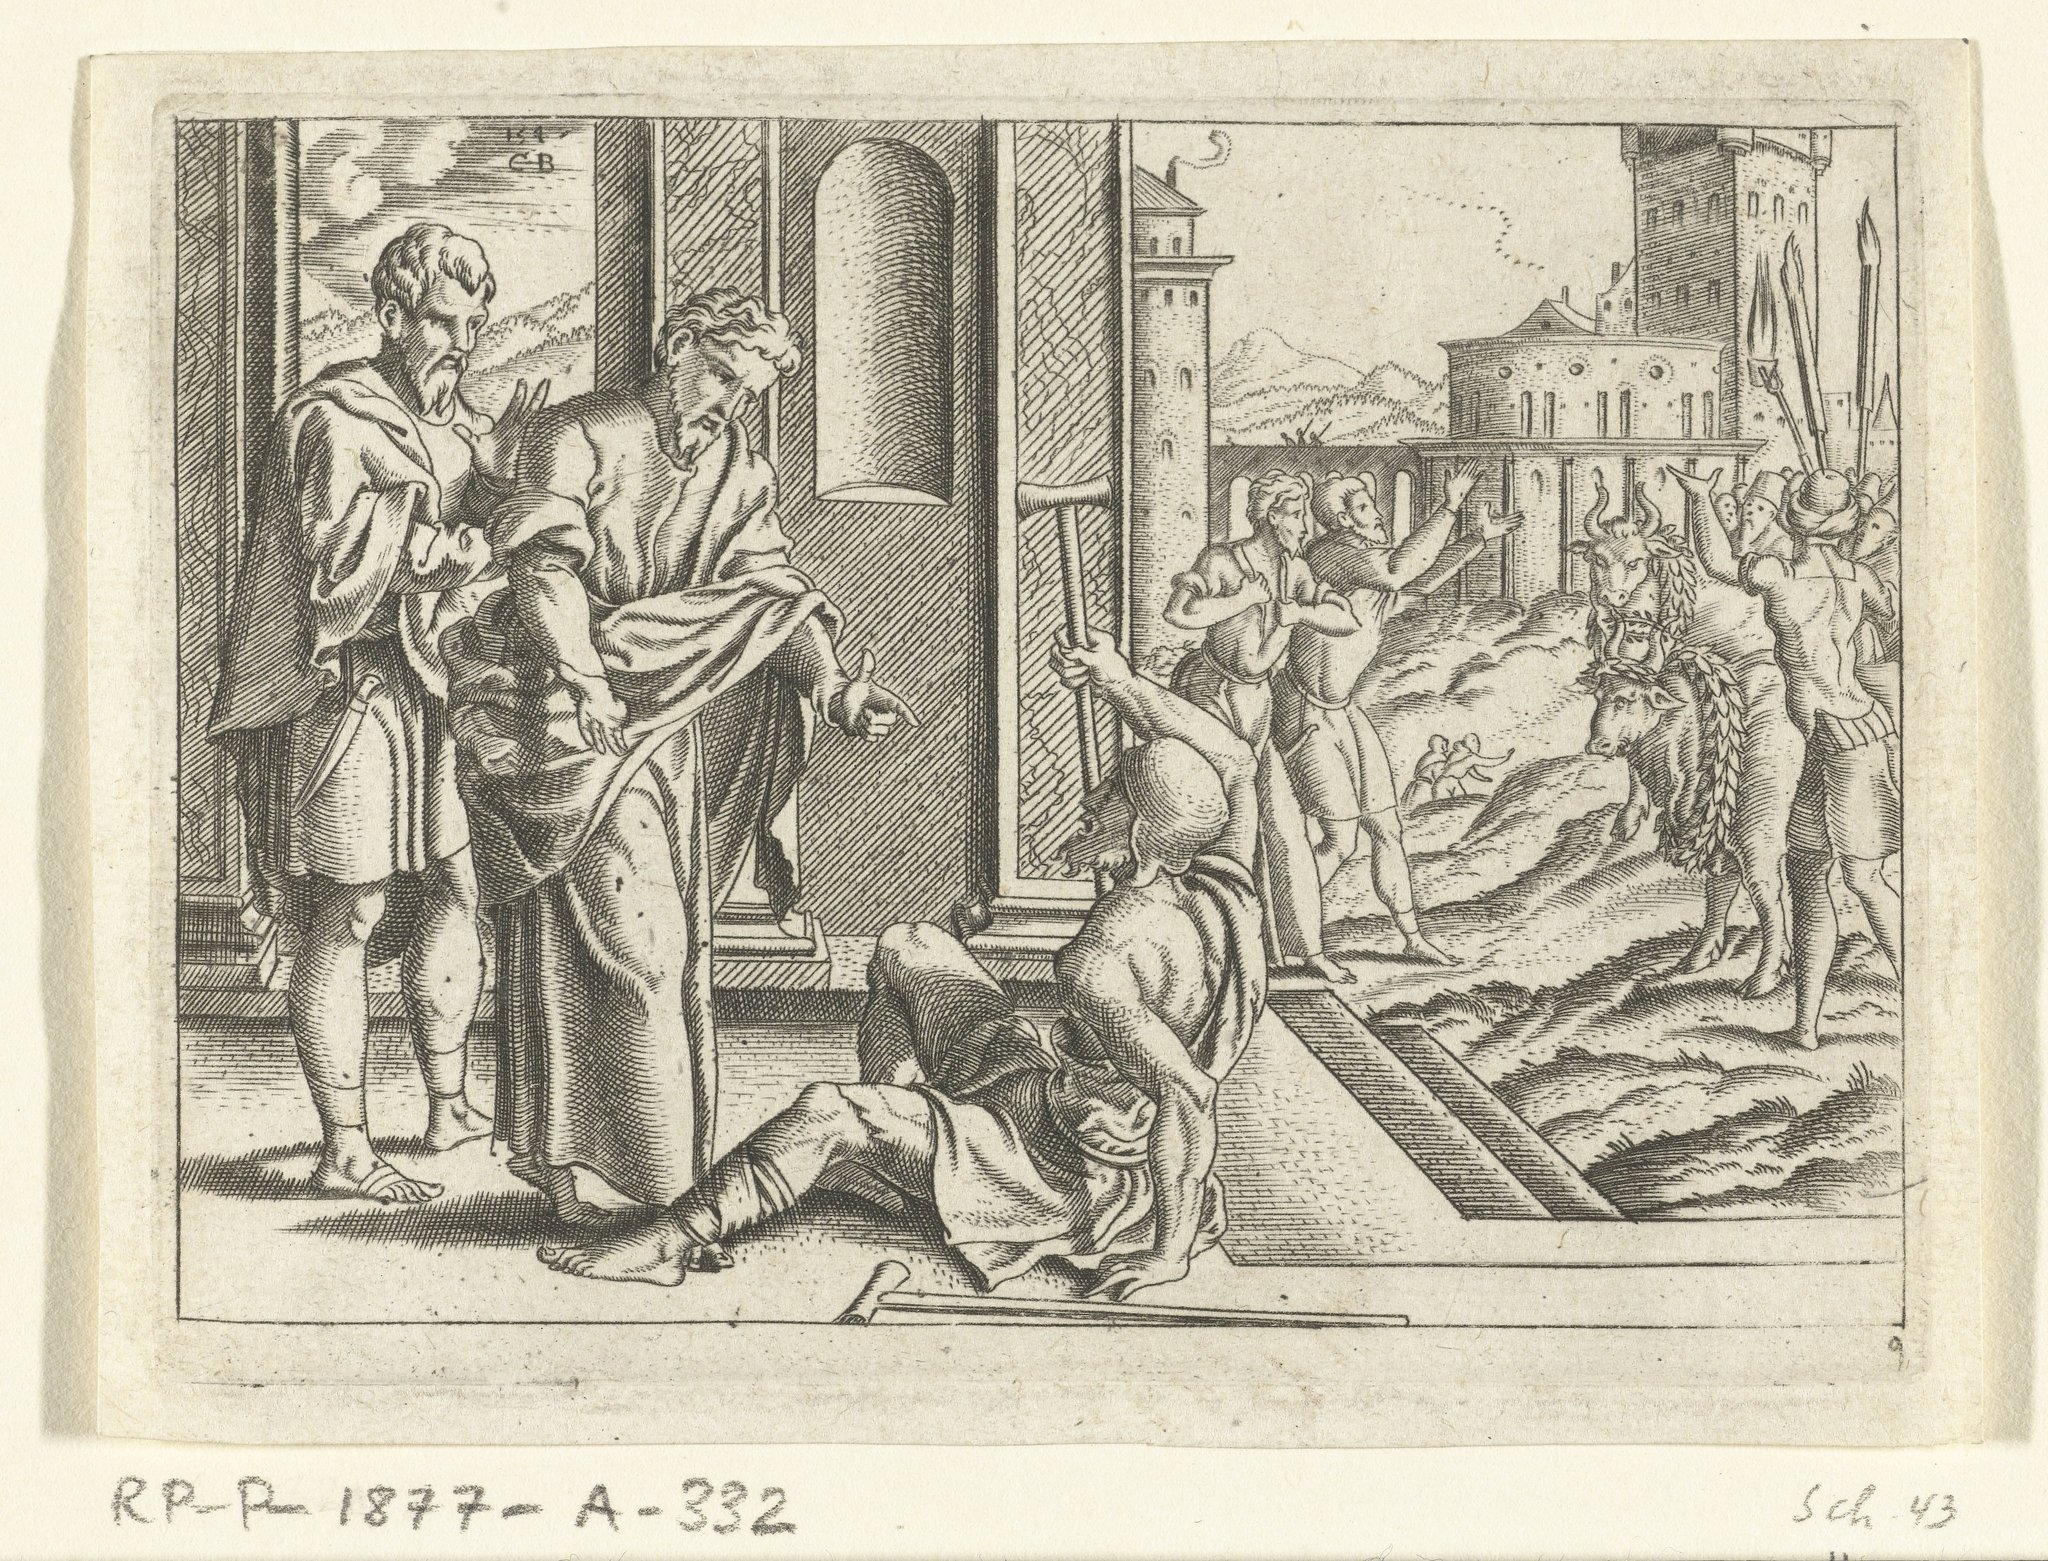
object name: print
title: Paulus geneest de man die niet kon lopen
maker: cornelis bos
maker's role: print maker, printer, publisher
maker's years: 1510-1566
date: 1547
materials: paper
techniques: engraving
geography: groningen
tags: paul and barnabas heal the feet of a man; the people of lystra think they are mercury and jupiter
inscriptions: collector's mark: Lugt 2228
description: De voorstelling is gebaseerd op Handelingen 14:8-11. In Lystra wordt de apostel Paulus omringd door mensen die om hulp of genezing vragen. Met een gebaar geneest Paulus de voeten van de zittende man. De mensen uit Lystra denken dat Barnabas en Paulus Goden moeten zijn. De priester van een nabijgelegen tempel brengt twee versierde stieren naar de stadspoort om ze te offeren. Op de achtergrond is, links in beeld, een zuil te zien van de tempel van Jupiter. Prent uit een serie van 10 prenten met scènes uit het leven van de apostel Paulus.